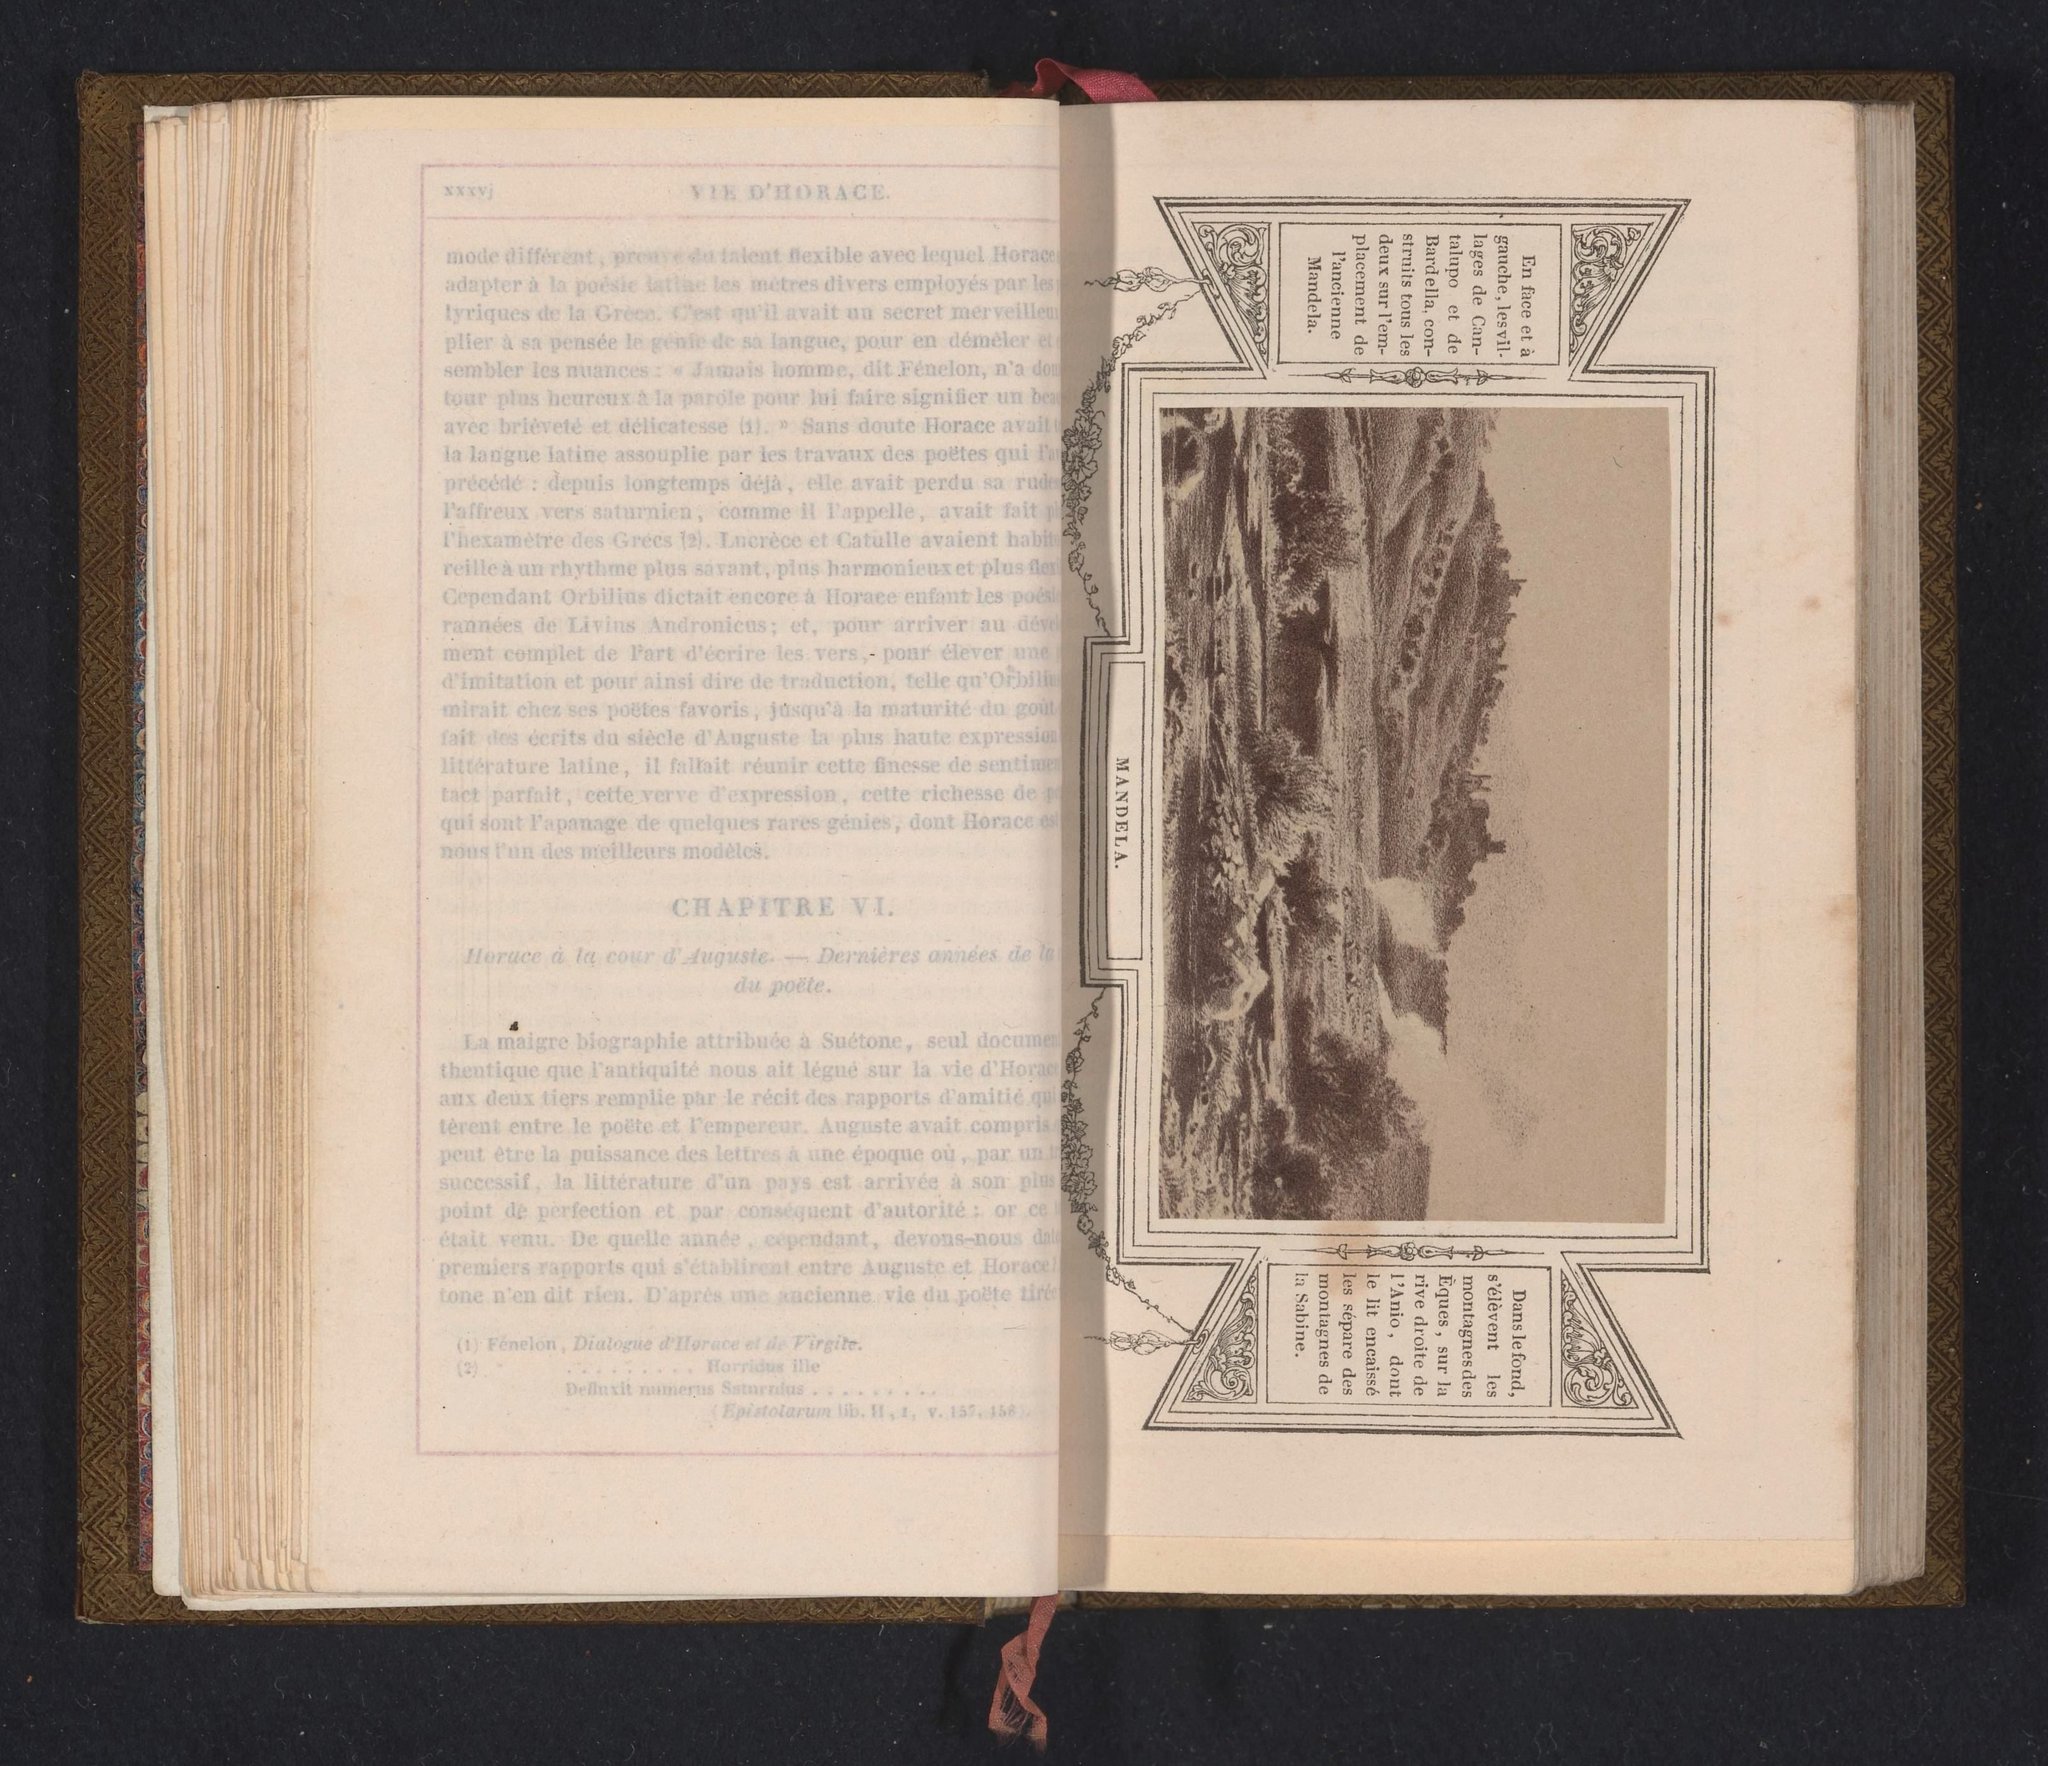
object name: photograph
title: Mandela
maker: Anonymous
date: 1850-1855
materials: photographic support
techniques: albumen print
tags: city-view in general; 'veduta'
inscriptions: inscription: ‘En face (...) la Sabine.’